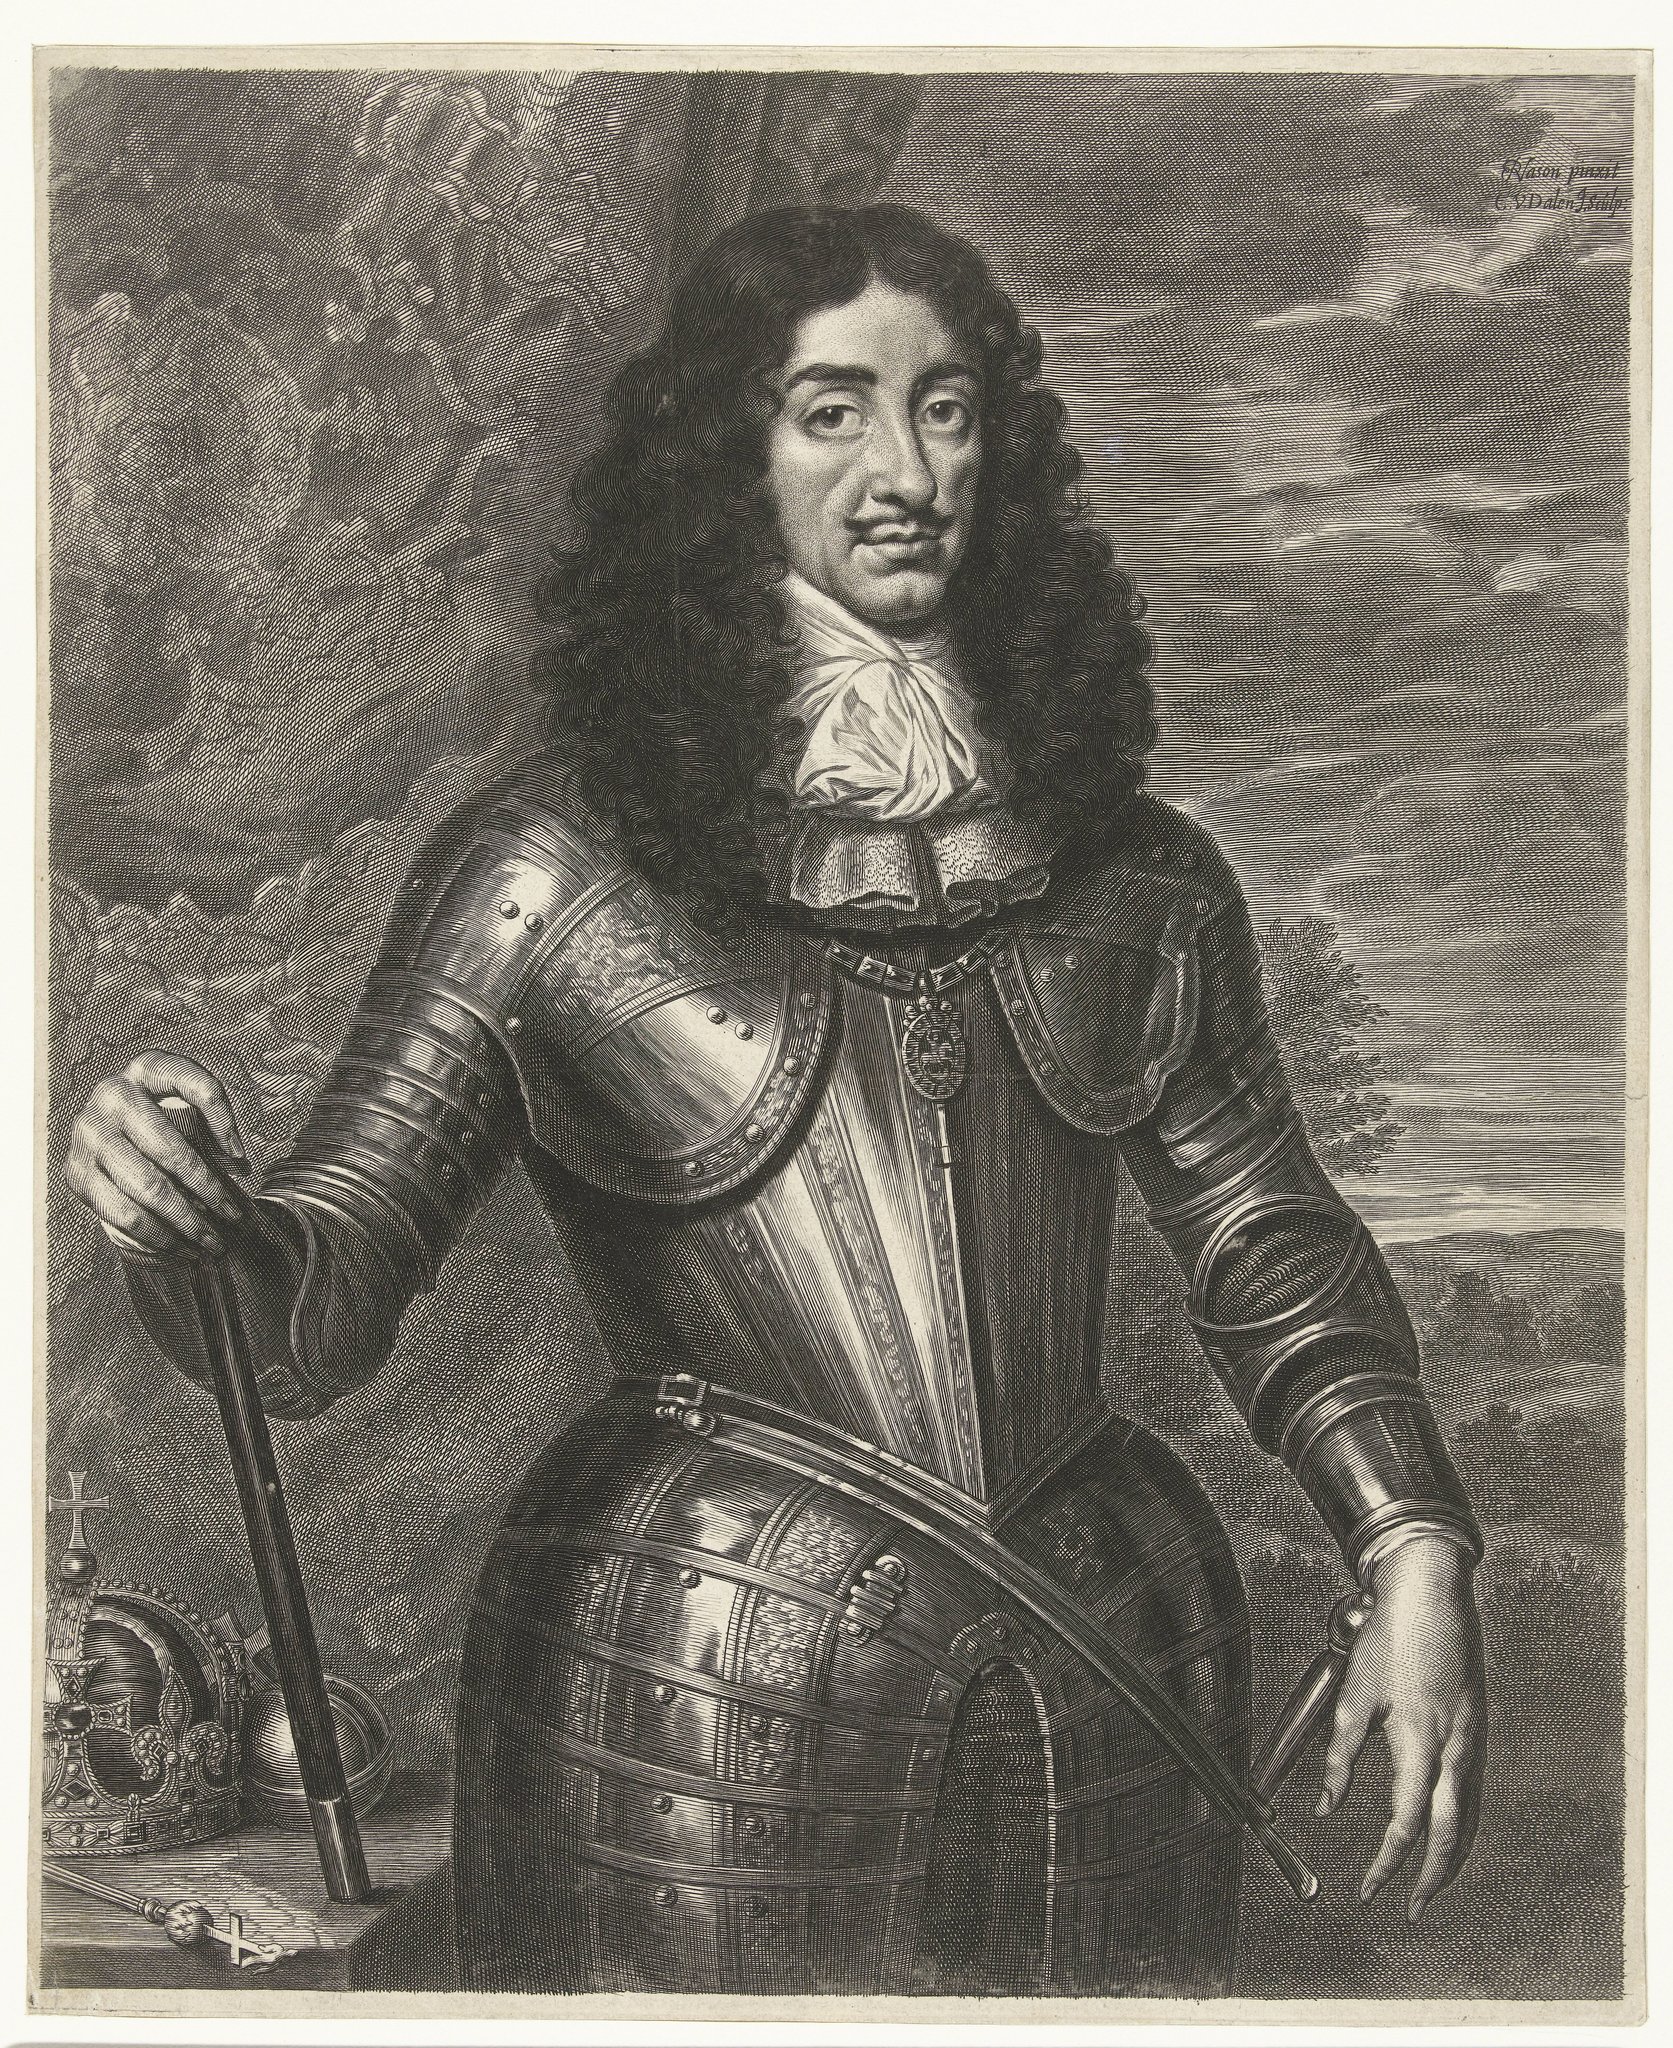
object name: print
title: Portret van keizer Leopold I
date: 1648-1664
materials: paper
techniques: engraving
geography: amsterdam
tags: vienna, leopold i (keizer van duitsland), orb (symbol of sovereignty; sphere with cross on top)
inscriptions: collector's mark: Lugt 2228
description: Prent naar schilderij van Pieter Nason. Vergelijk de eerste staat waarop de geportretteerde door ontbreken van enkele attributen een andere identiteit heeft, namelijk koning Karel II.